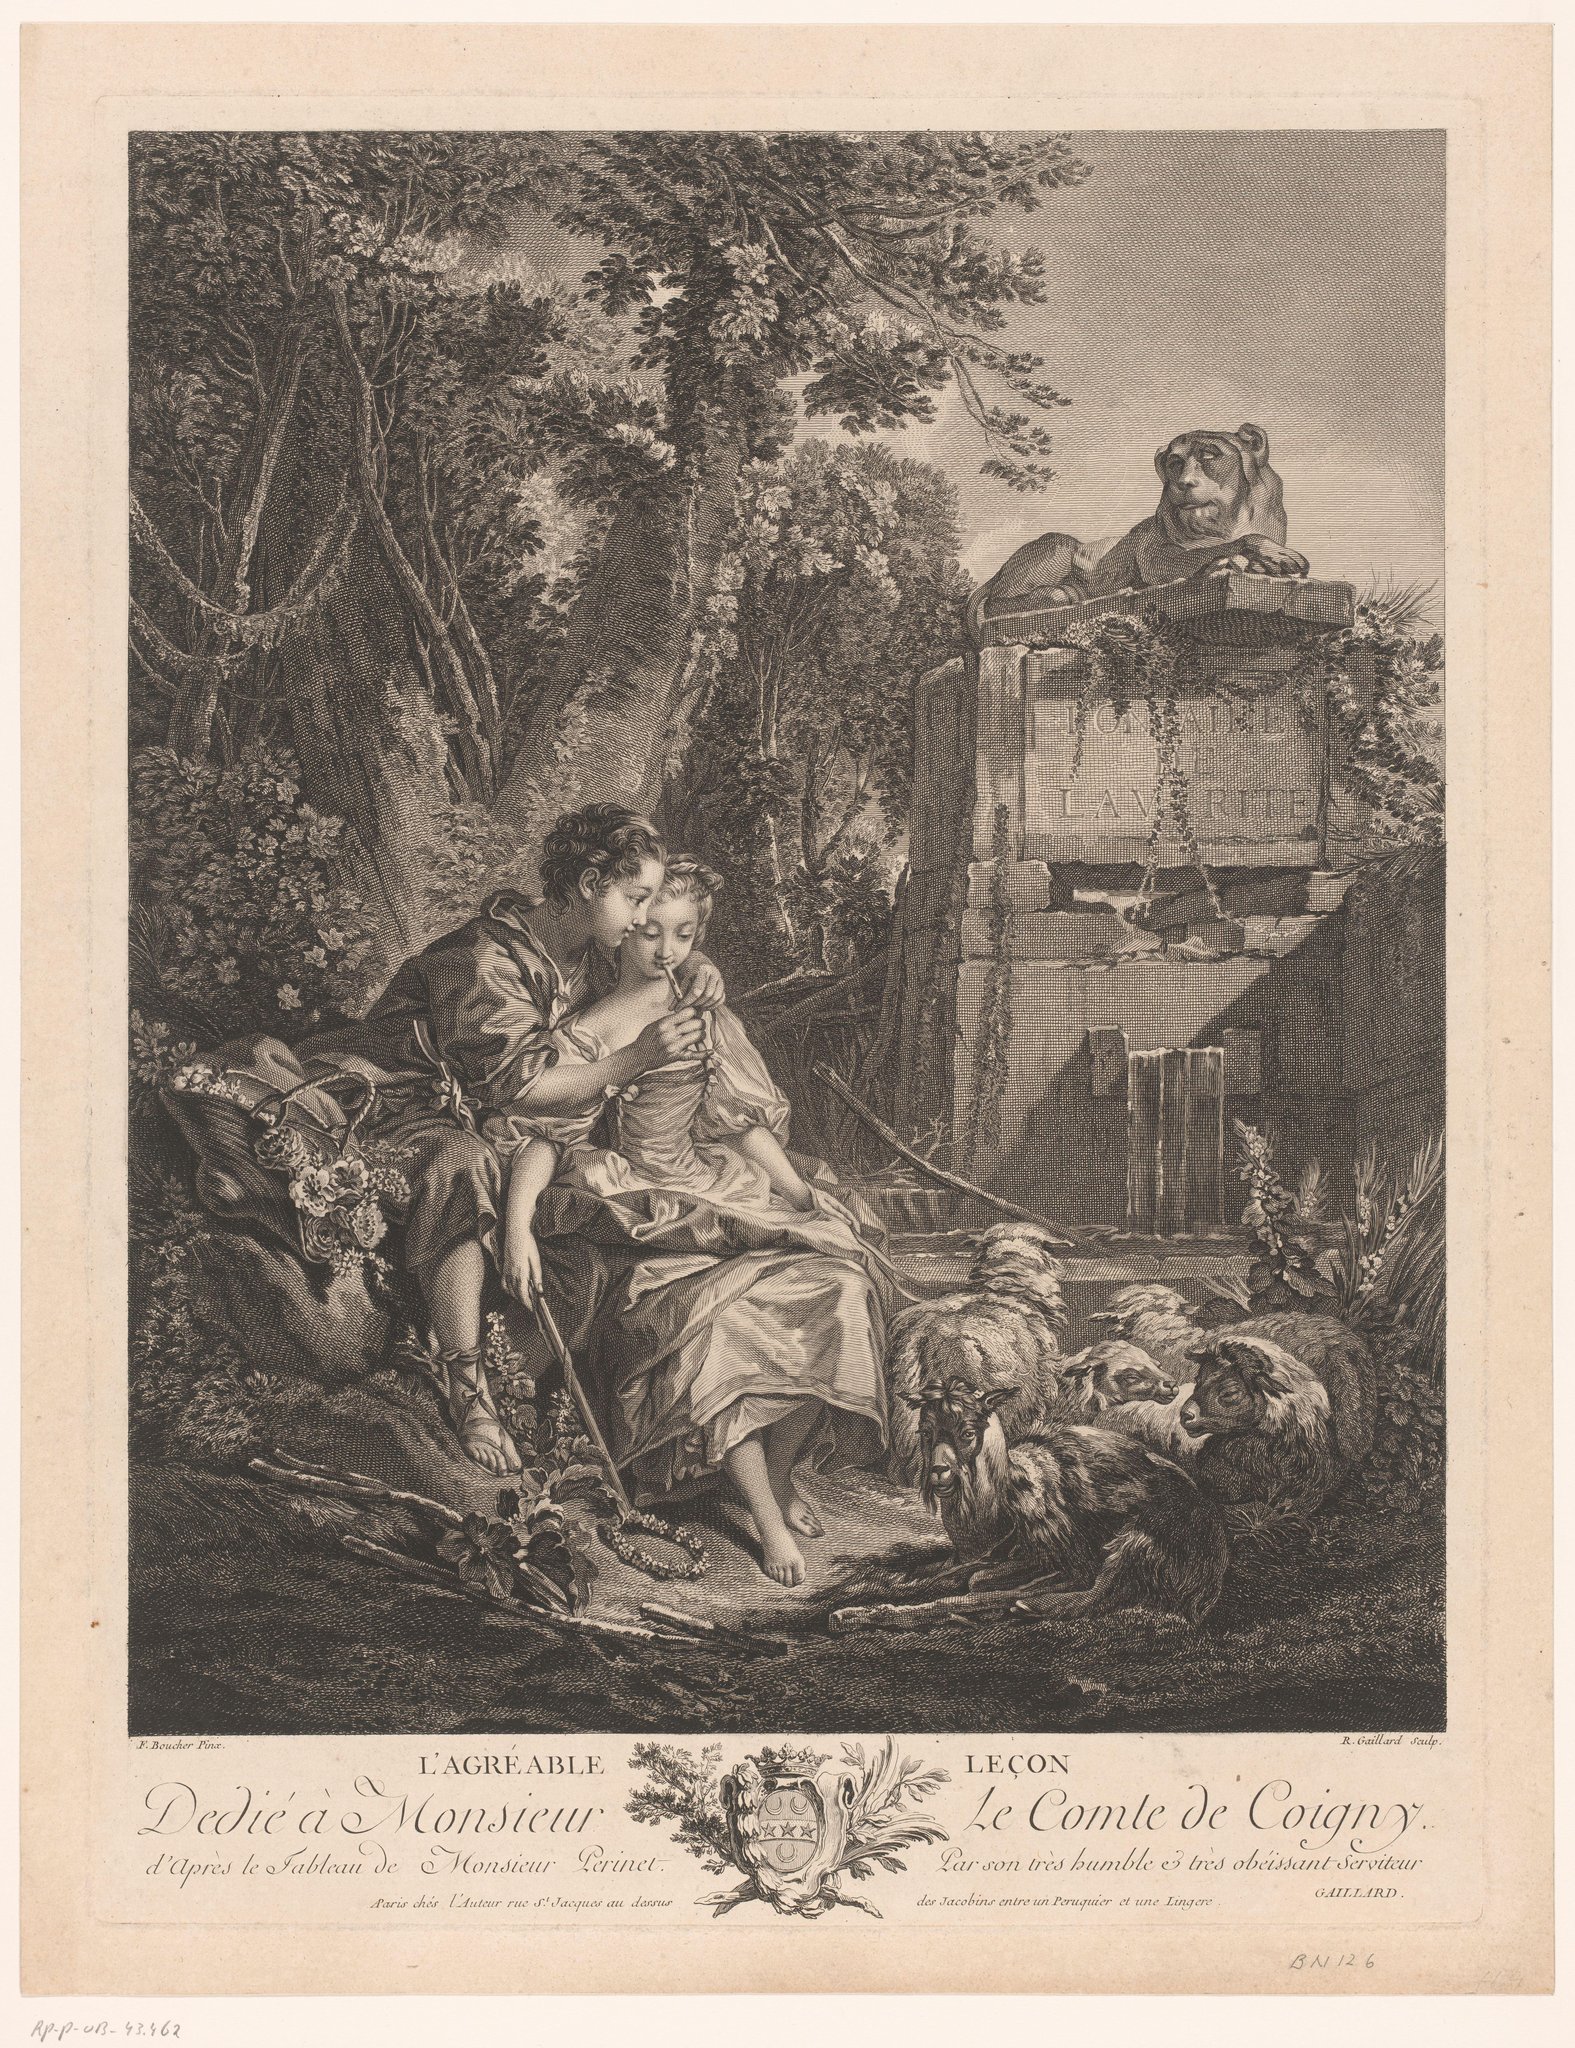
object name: print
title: L'Agréable Leçon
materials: paper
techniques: engraving, etching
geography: paris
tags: herding, herdsman, herdswoman, shepherd, shepherdess, cowherd, etc., flute, aulos, tibia